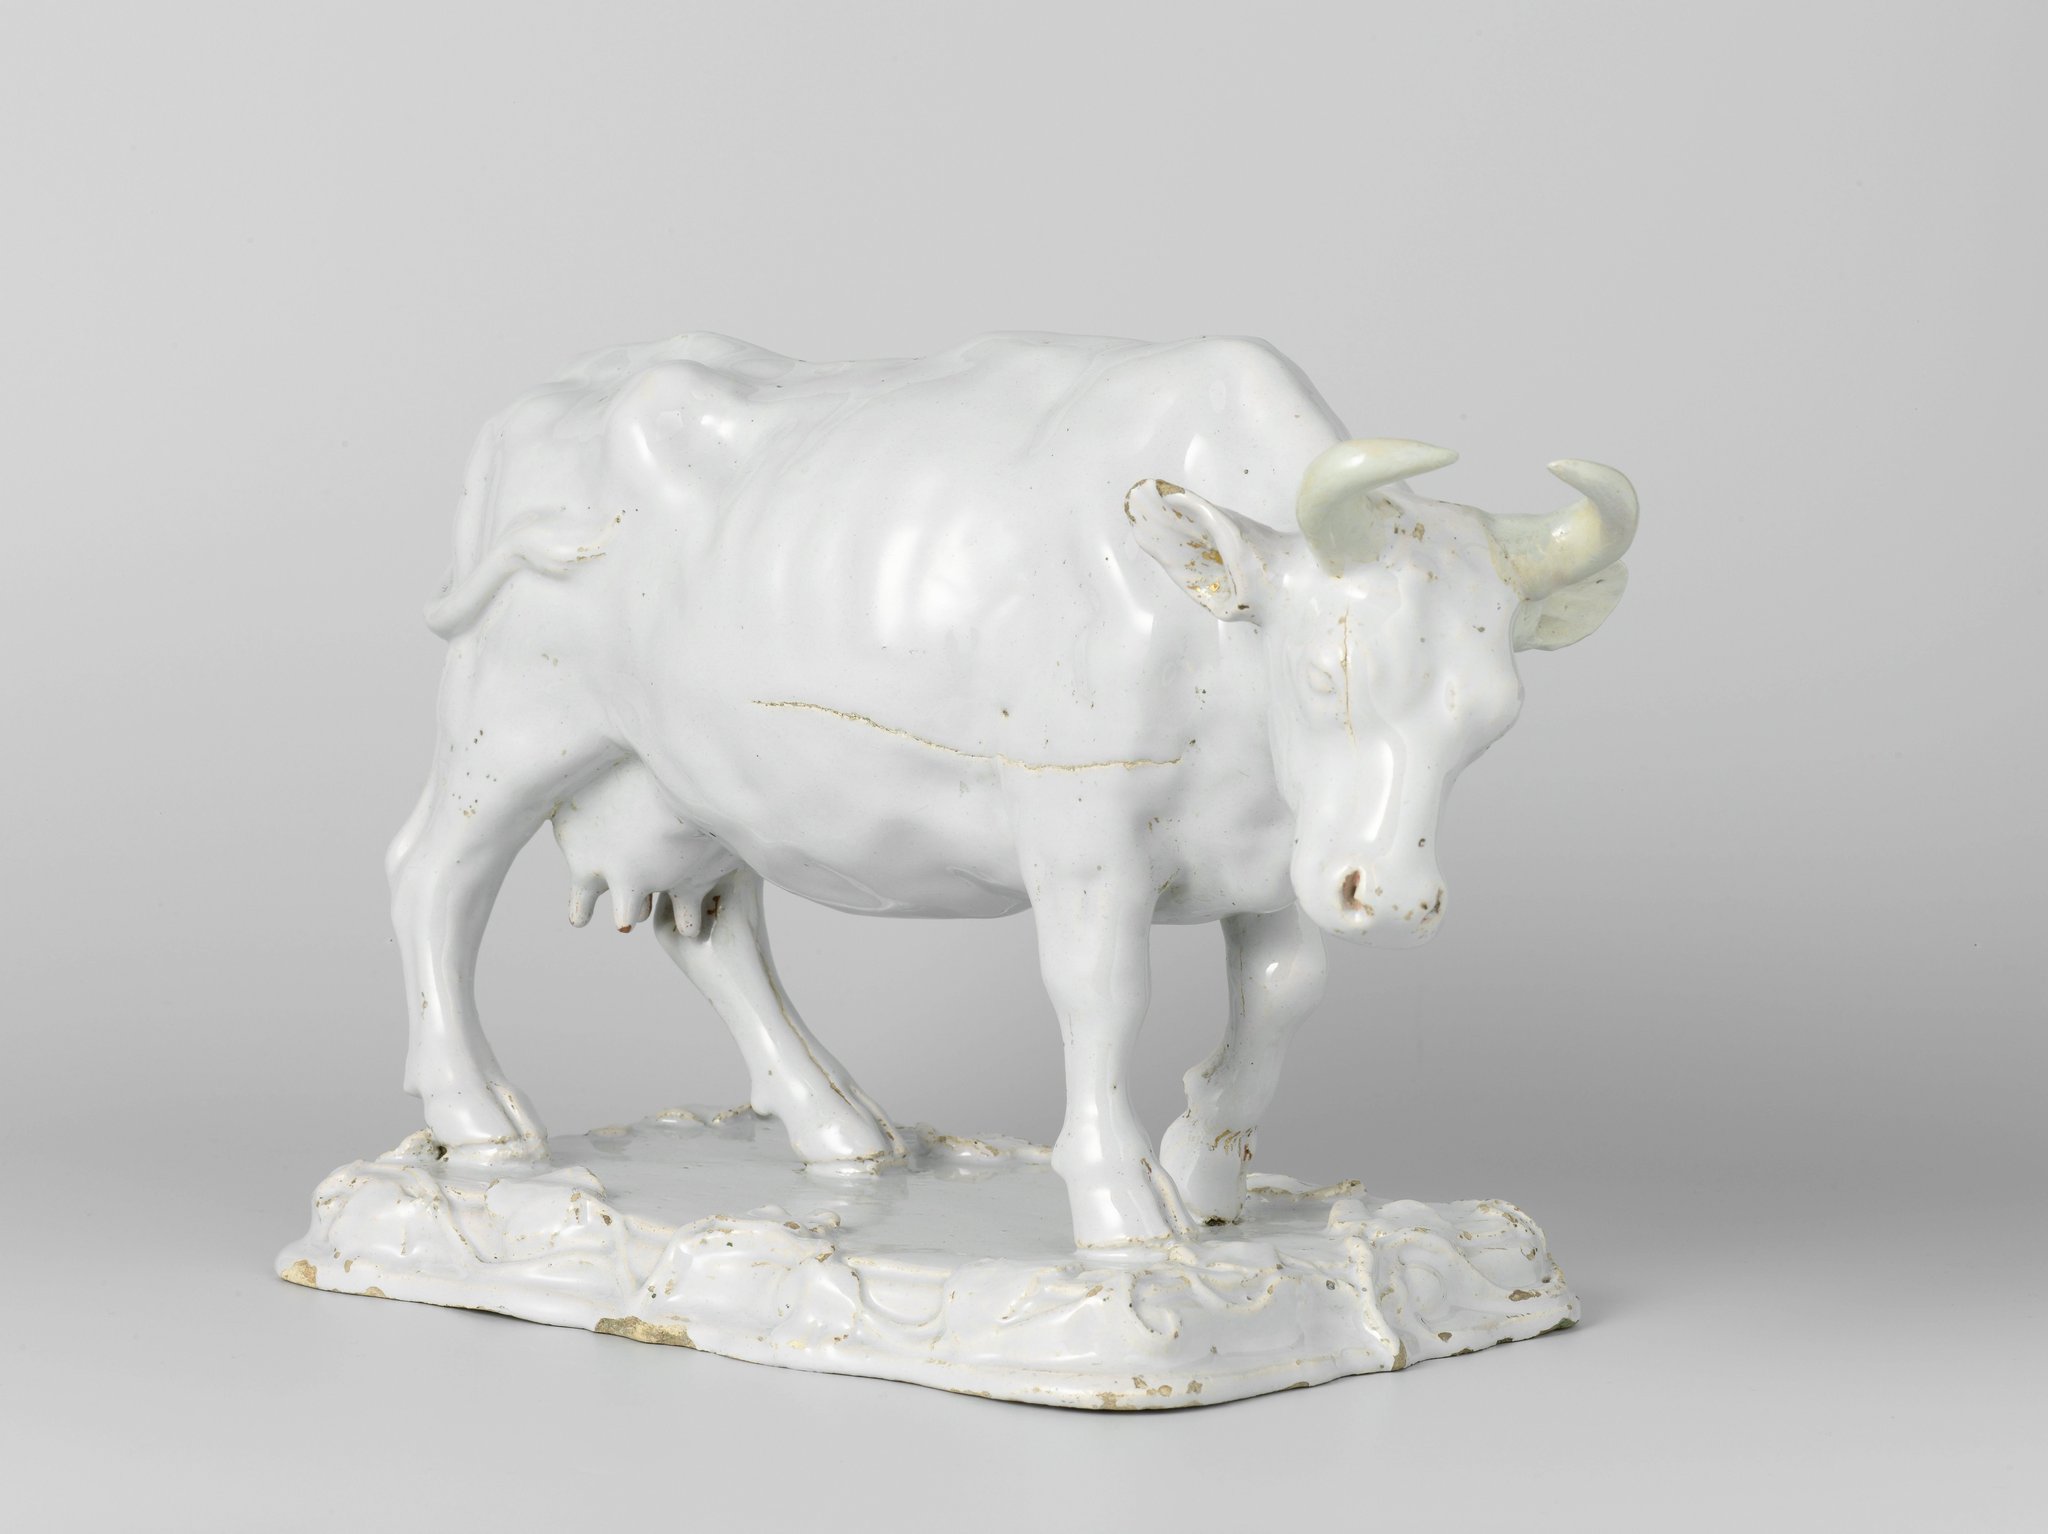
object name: dierfiguur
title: Koe, wit geglazuurd.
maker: Anonymous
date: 1725-1770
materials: faience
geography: delft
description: Dierenfiguur van faience, voorstellende een koe. Wit geglazuurd.